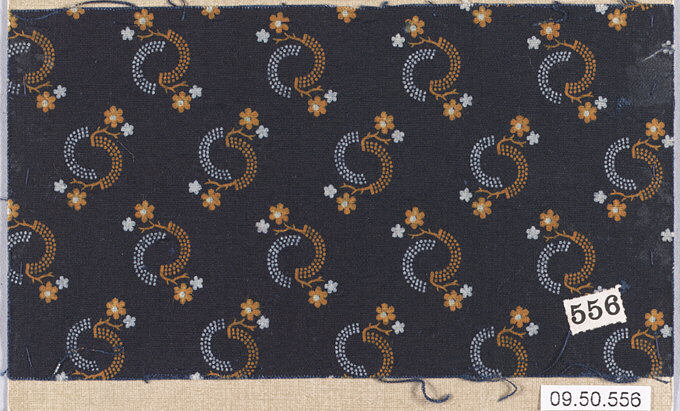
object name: piece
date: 1801-1900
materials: cotton